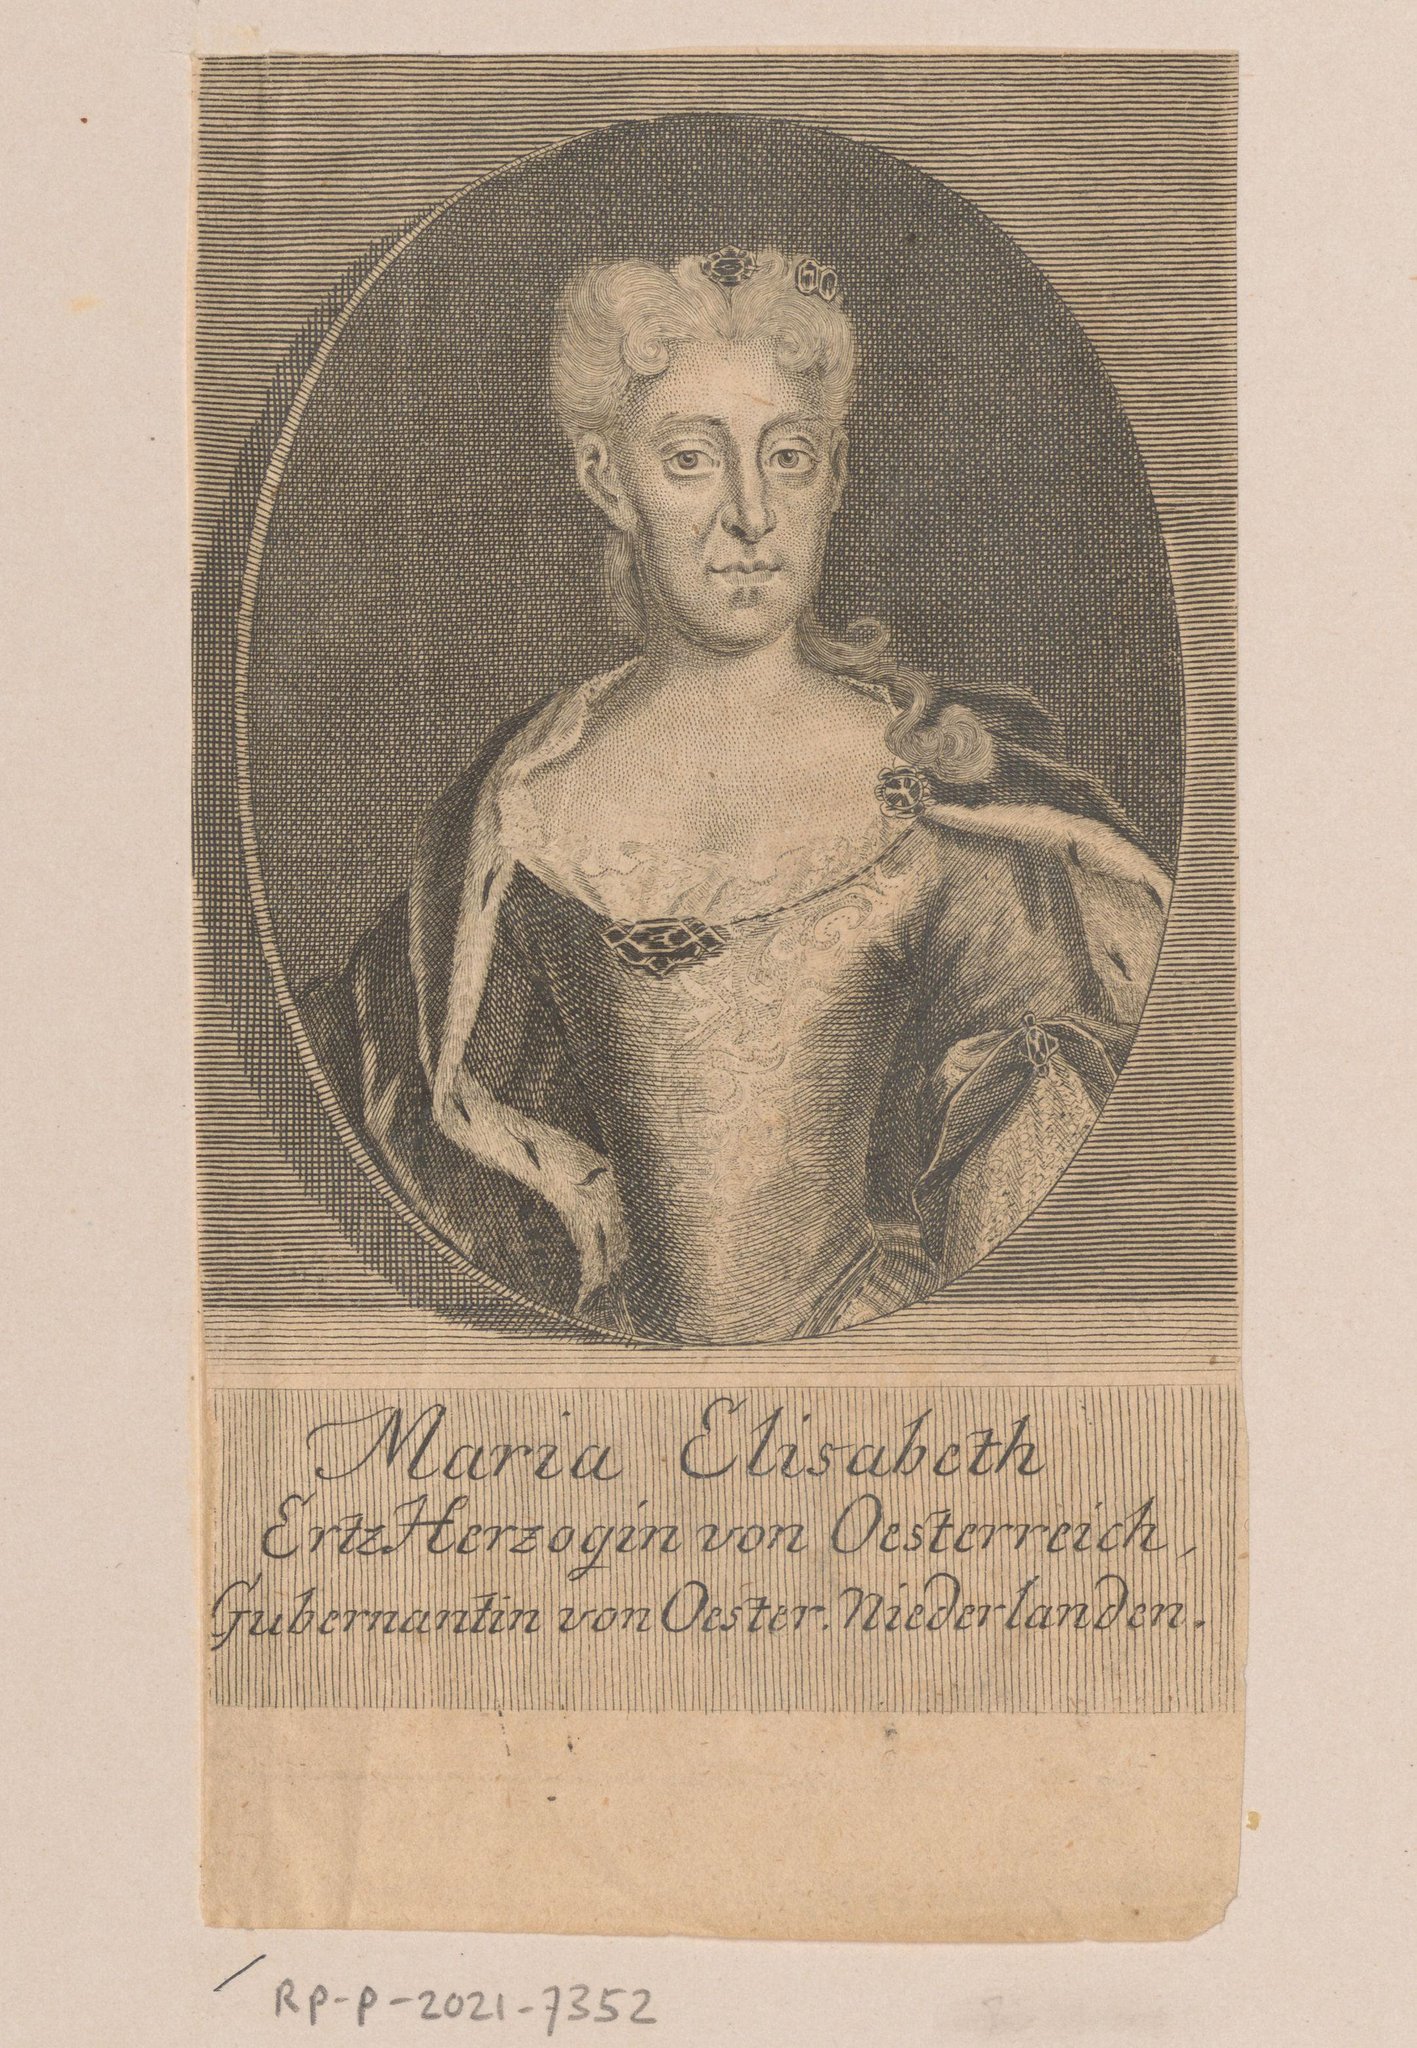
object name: print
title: Portret van Maria Elisabeth van Oostenrijk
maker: Anonymous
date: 1724-1741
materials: paper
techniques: engraving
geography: germany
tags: historical persons - bb - woman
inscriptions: number: ‘61’